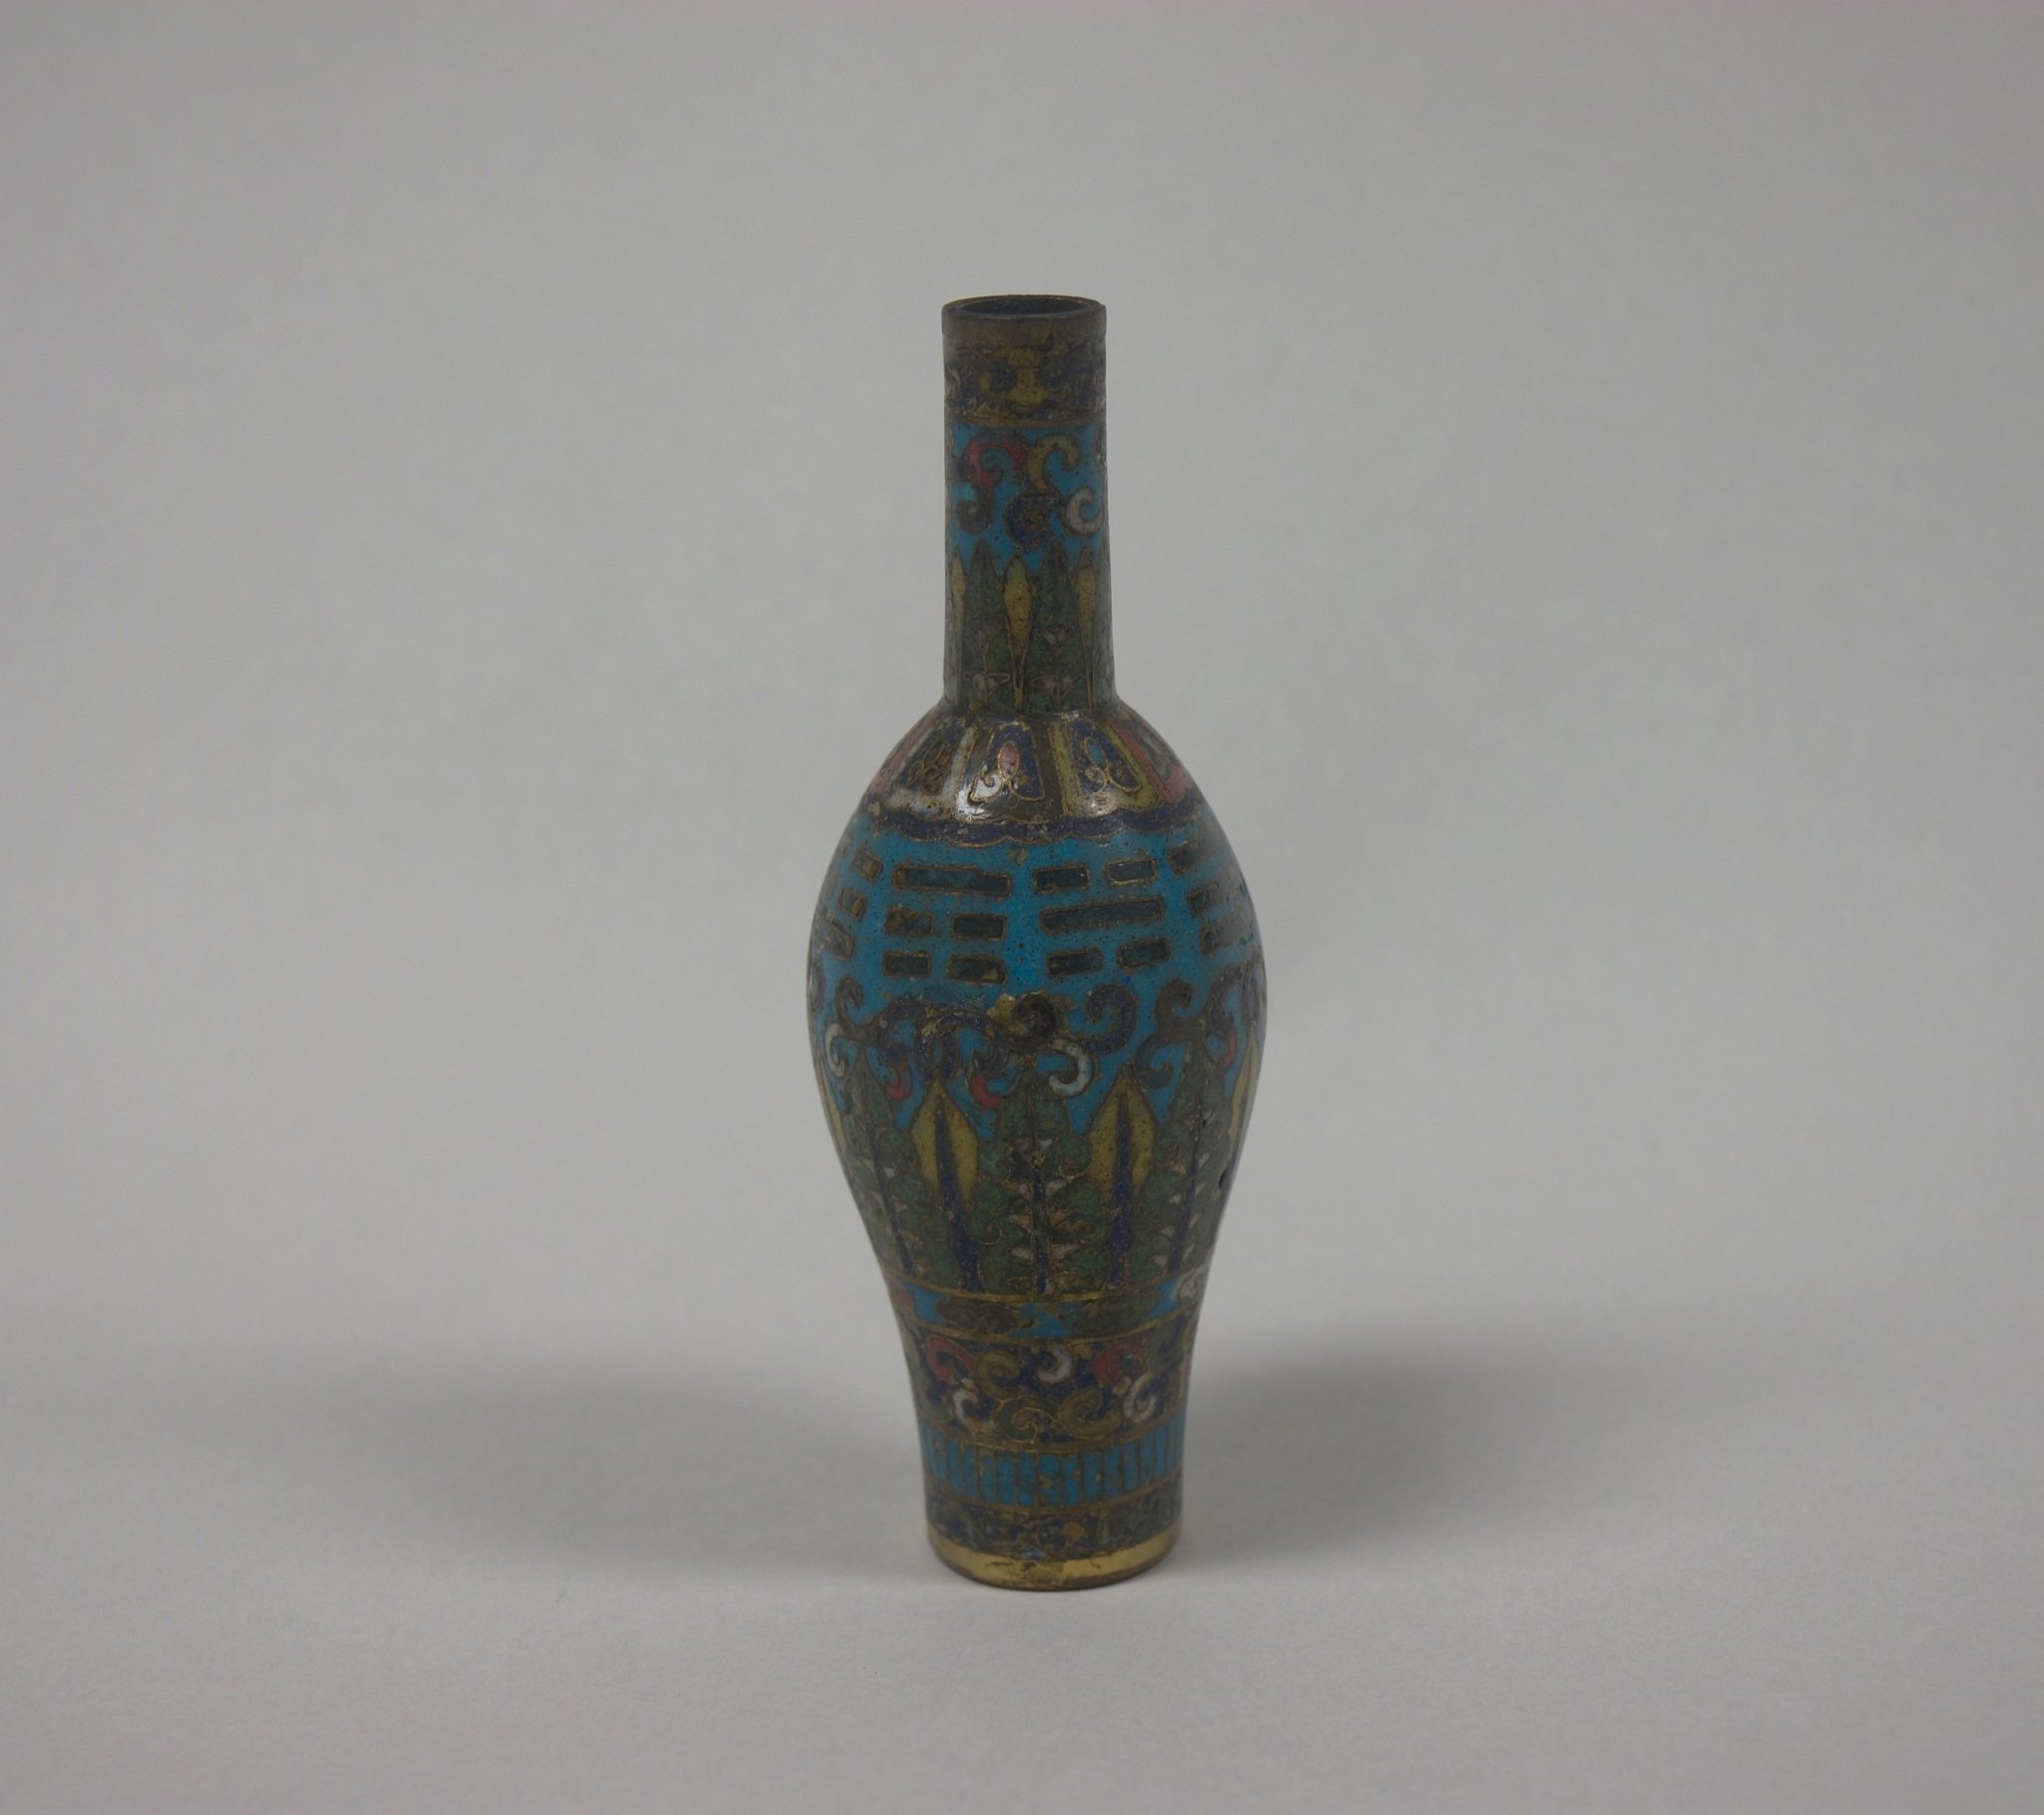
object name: bottle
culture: chinese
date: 1368-1644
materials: copper, enamel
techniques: enamel